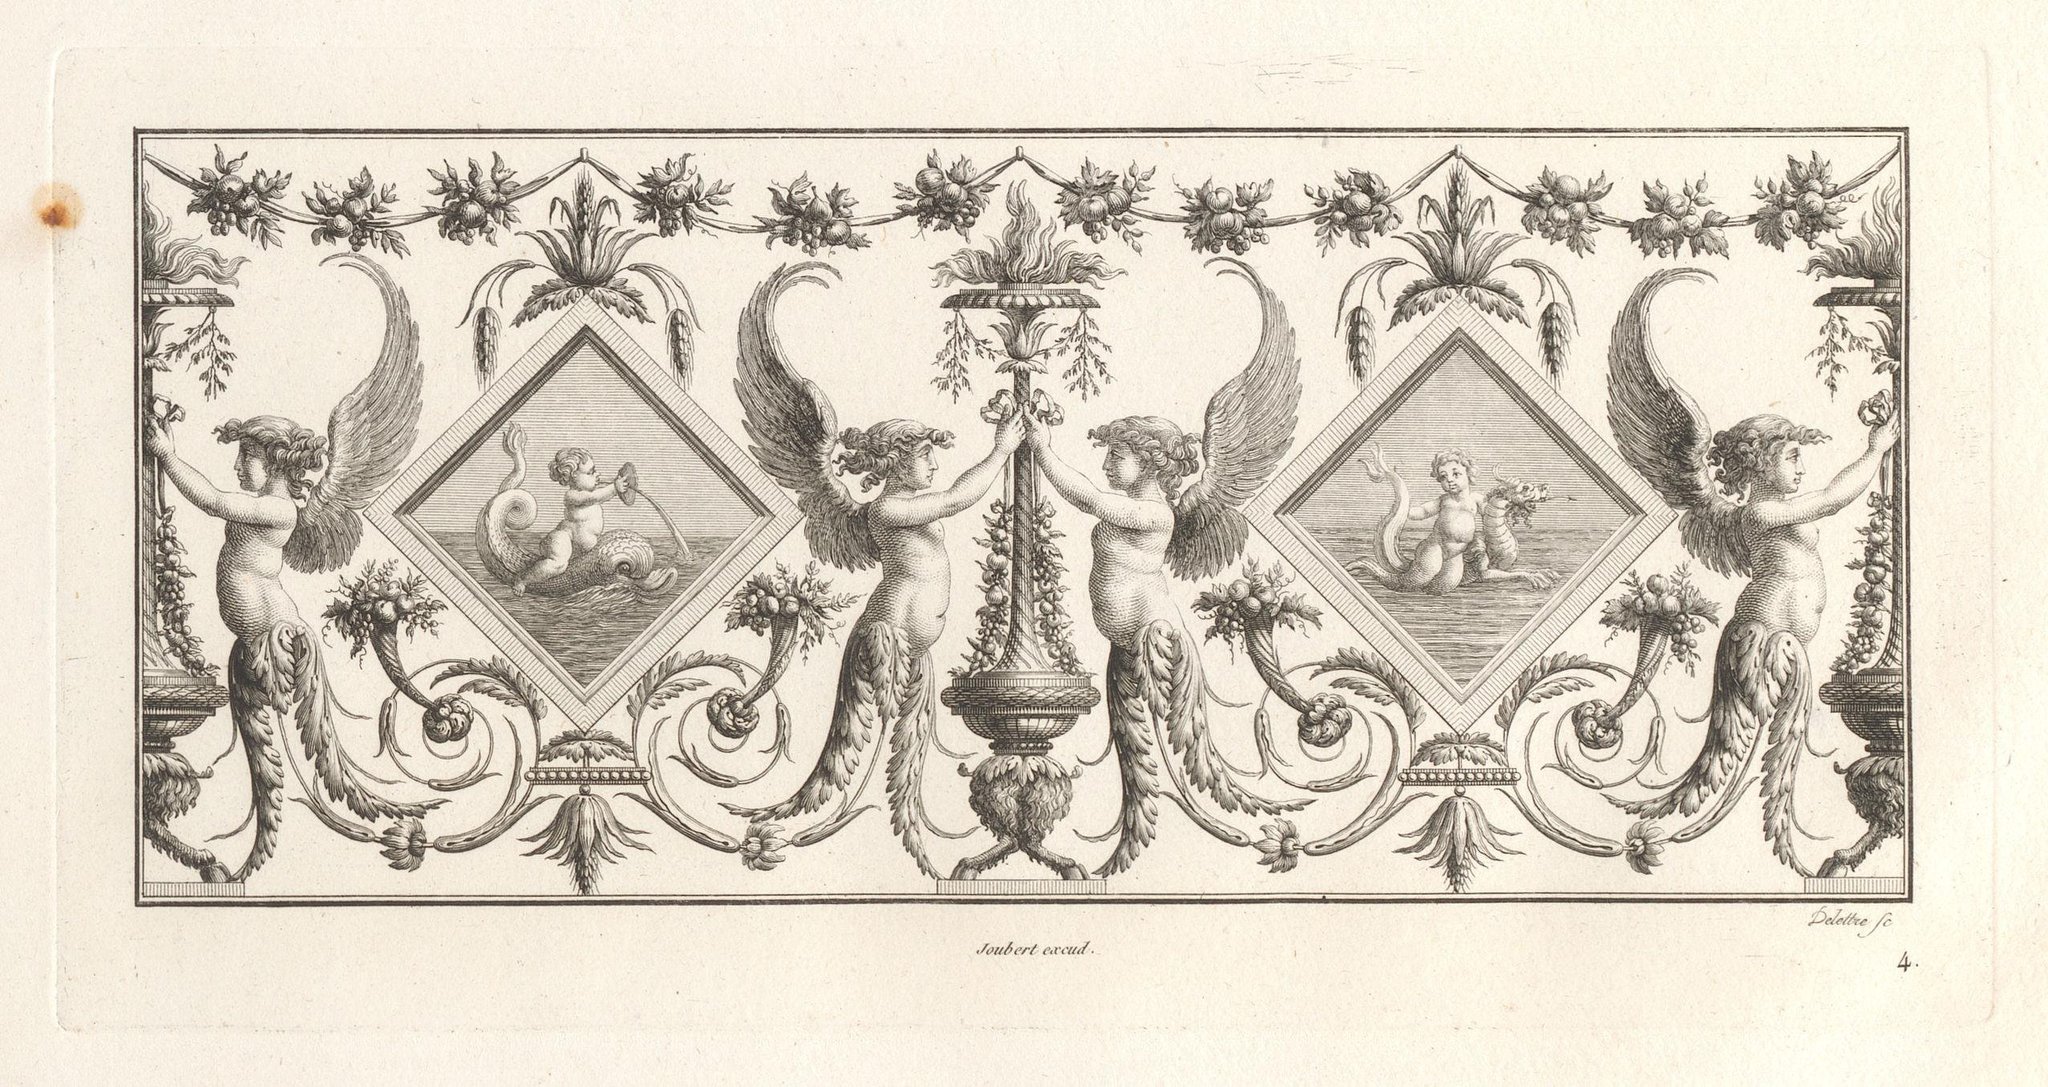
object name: album leaf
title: Arabesken, ontworpen door Pierre-Alexandre Le Prieur, tiende serie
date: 1802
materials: paper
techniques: engraving, etching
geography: paris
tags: dolphin ~ ornament, ornament ~ arabesque, monsters of the sea, fabulous beings with wings, cupids: 'amores', 'amoretti', 'putti', ornament derived from plant forms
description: Doordat dit album bestaat uit meerdere, deels eerder uitgegeven prentreeksen, is de datering niet consequent. Het geheel is op de titelpagina gedateerd op 1802. Deze reeks is niet afzonderlijk gedateerd. De serietitel voor het gehele werk is "Recueil d'arabesques, contenant les loges du Vatican". De andere serietitel is de titel van de specifieke reeks binnen het geheel.